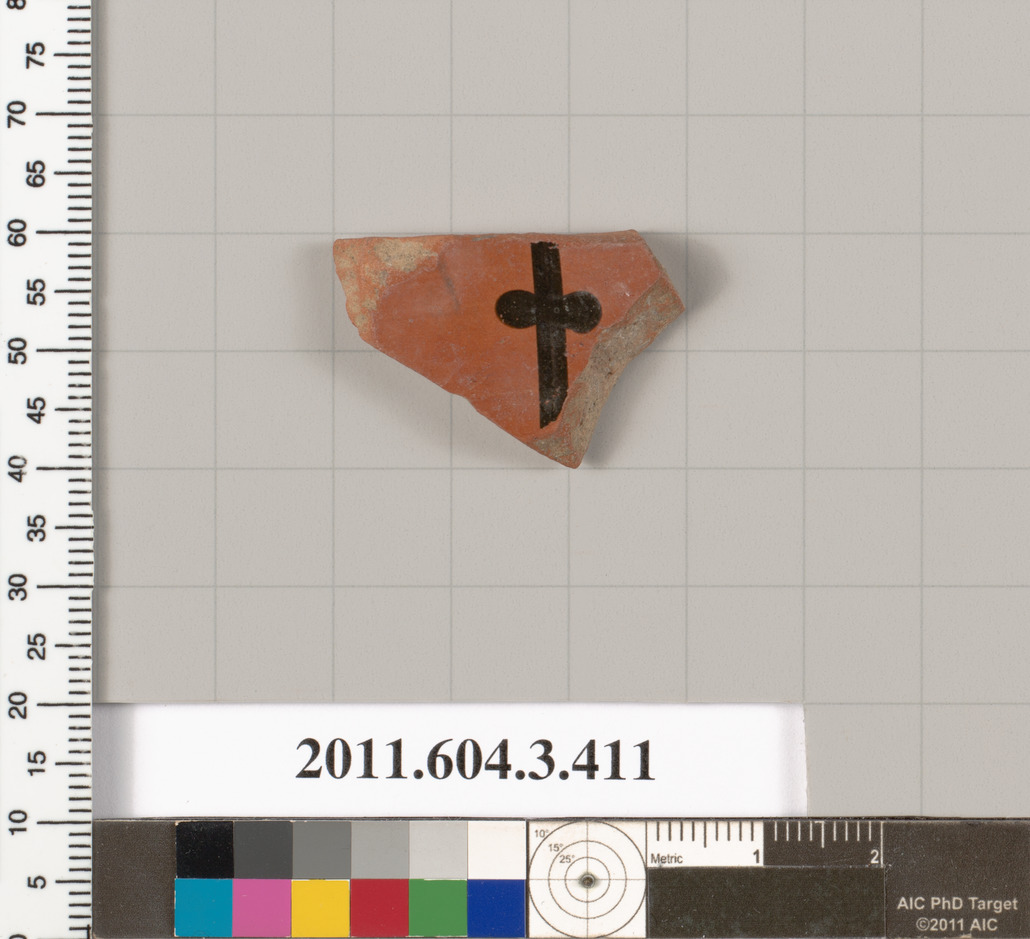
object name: neck amphora fragment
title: Terracotta fragment of a neck-amphora (jar)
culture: greek, attic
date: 500-468 BCE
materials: terracotta